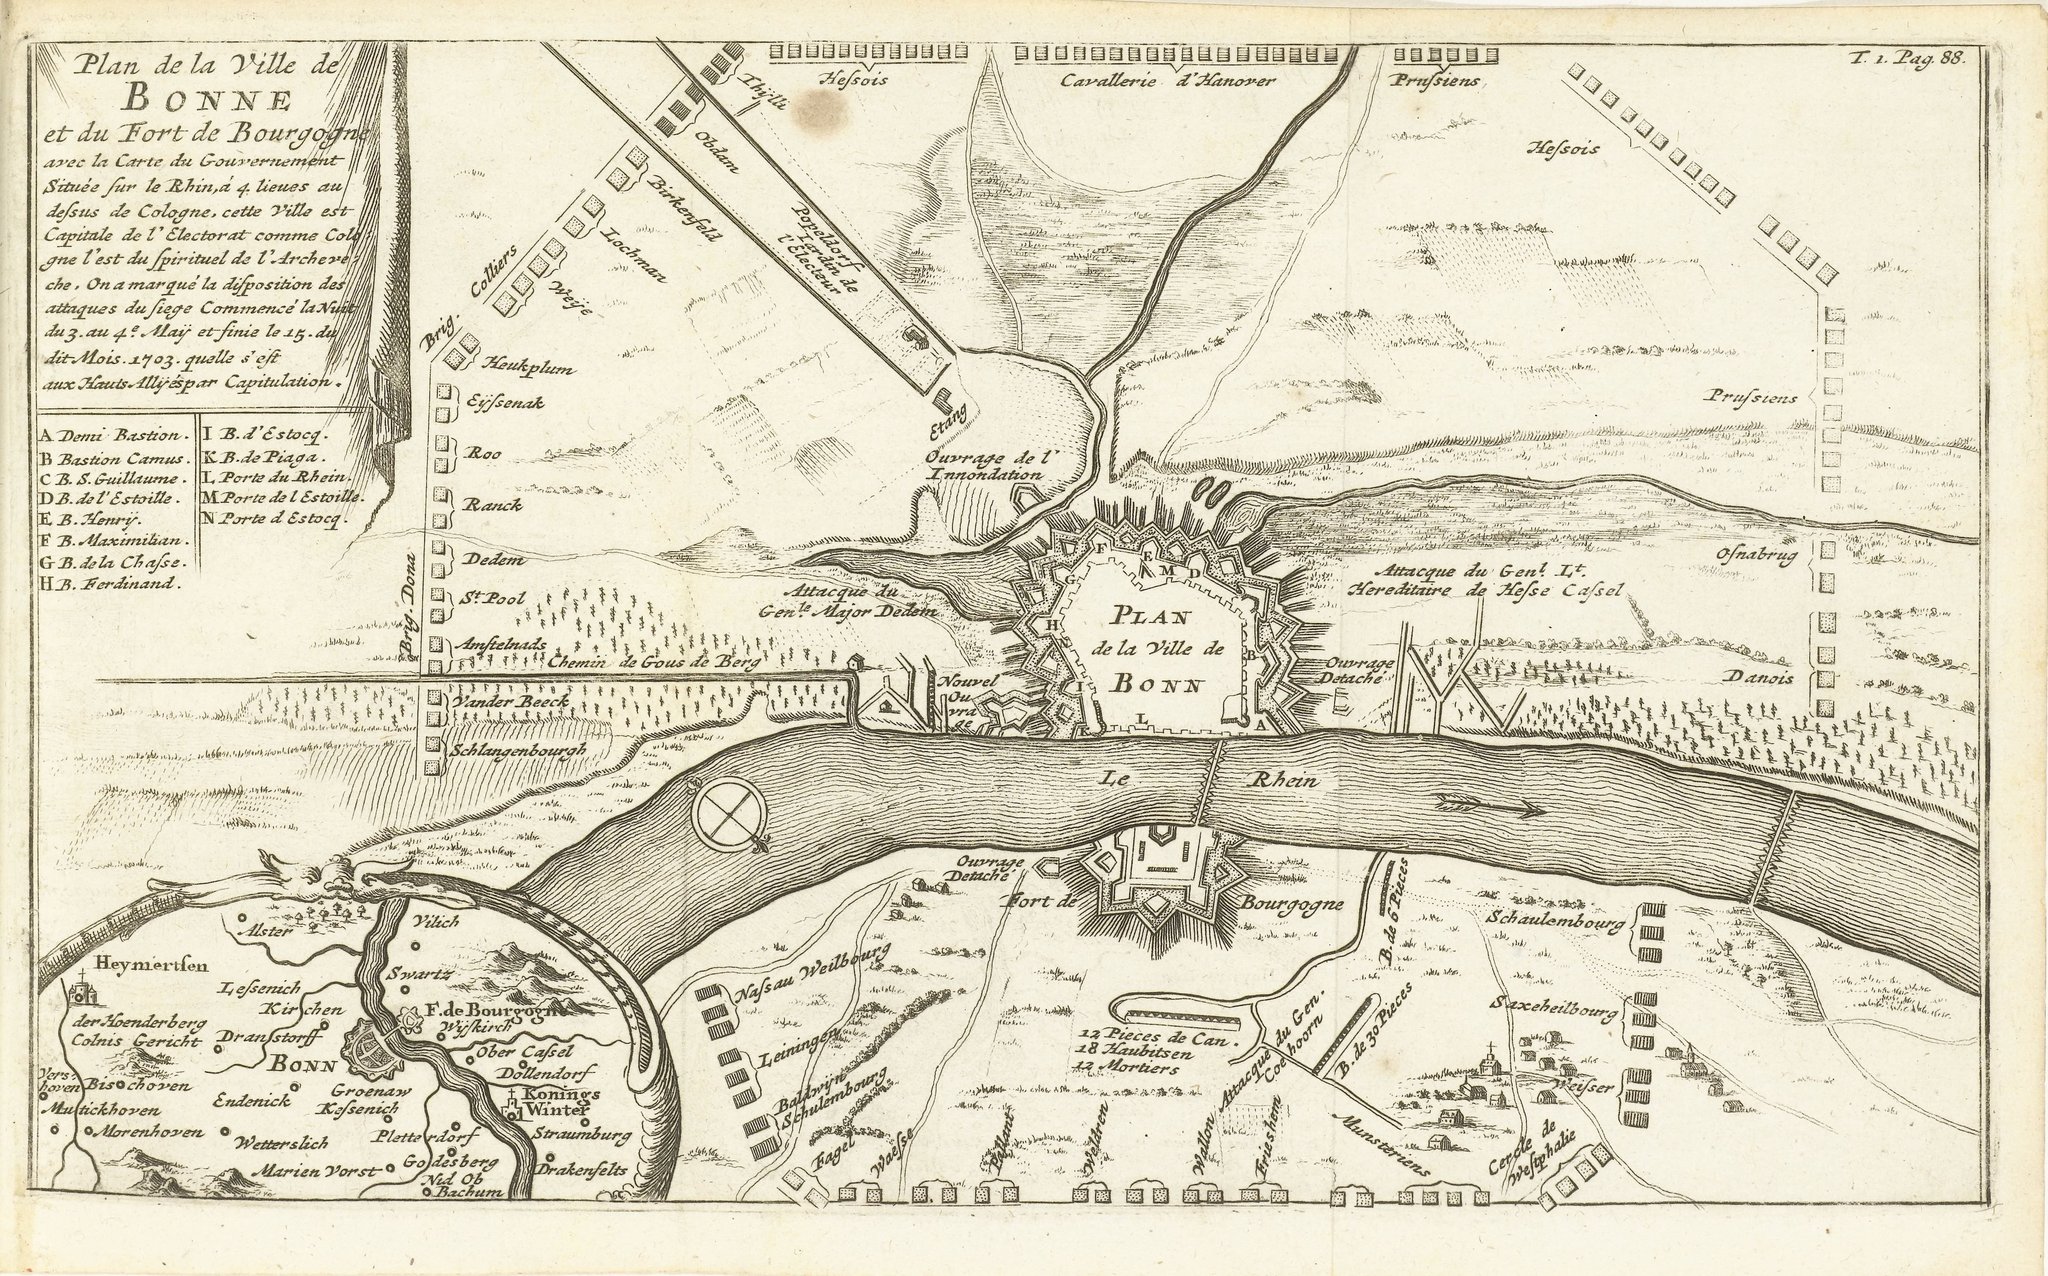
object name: map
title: Beleg van Bonn, 1703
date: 1716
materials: paper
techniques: etching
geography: amsterdam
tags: johan willem friso (prins van oranje-nassau), siege, position war, maps of cities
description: Kaart met het beleg van Bonn, veroverd op de Fransen door de bondgenoten op 15 mei 1703, na beleg vanaf 5 mei. Illustratie in de Nederlandse vertaling uit 1716 van J. Lamigue, Het leven van Zyne Hoogheit Johan Willem Friso, dl. I, p. 88/89.